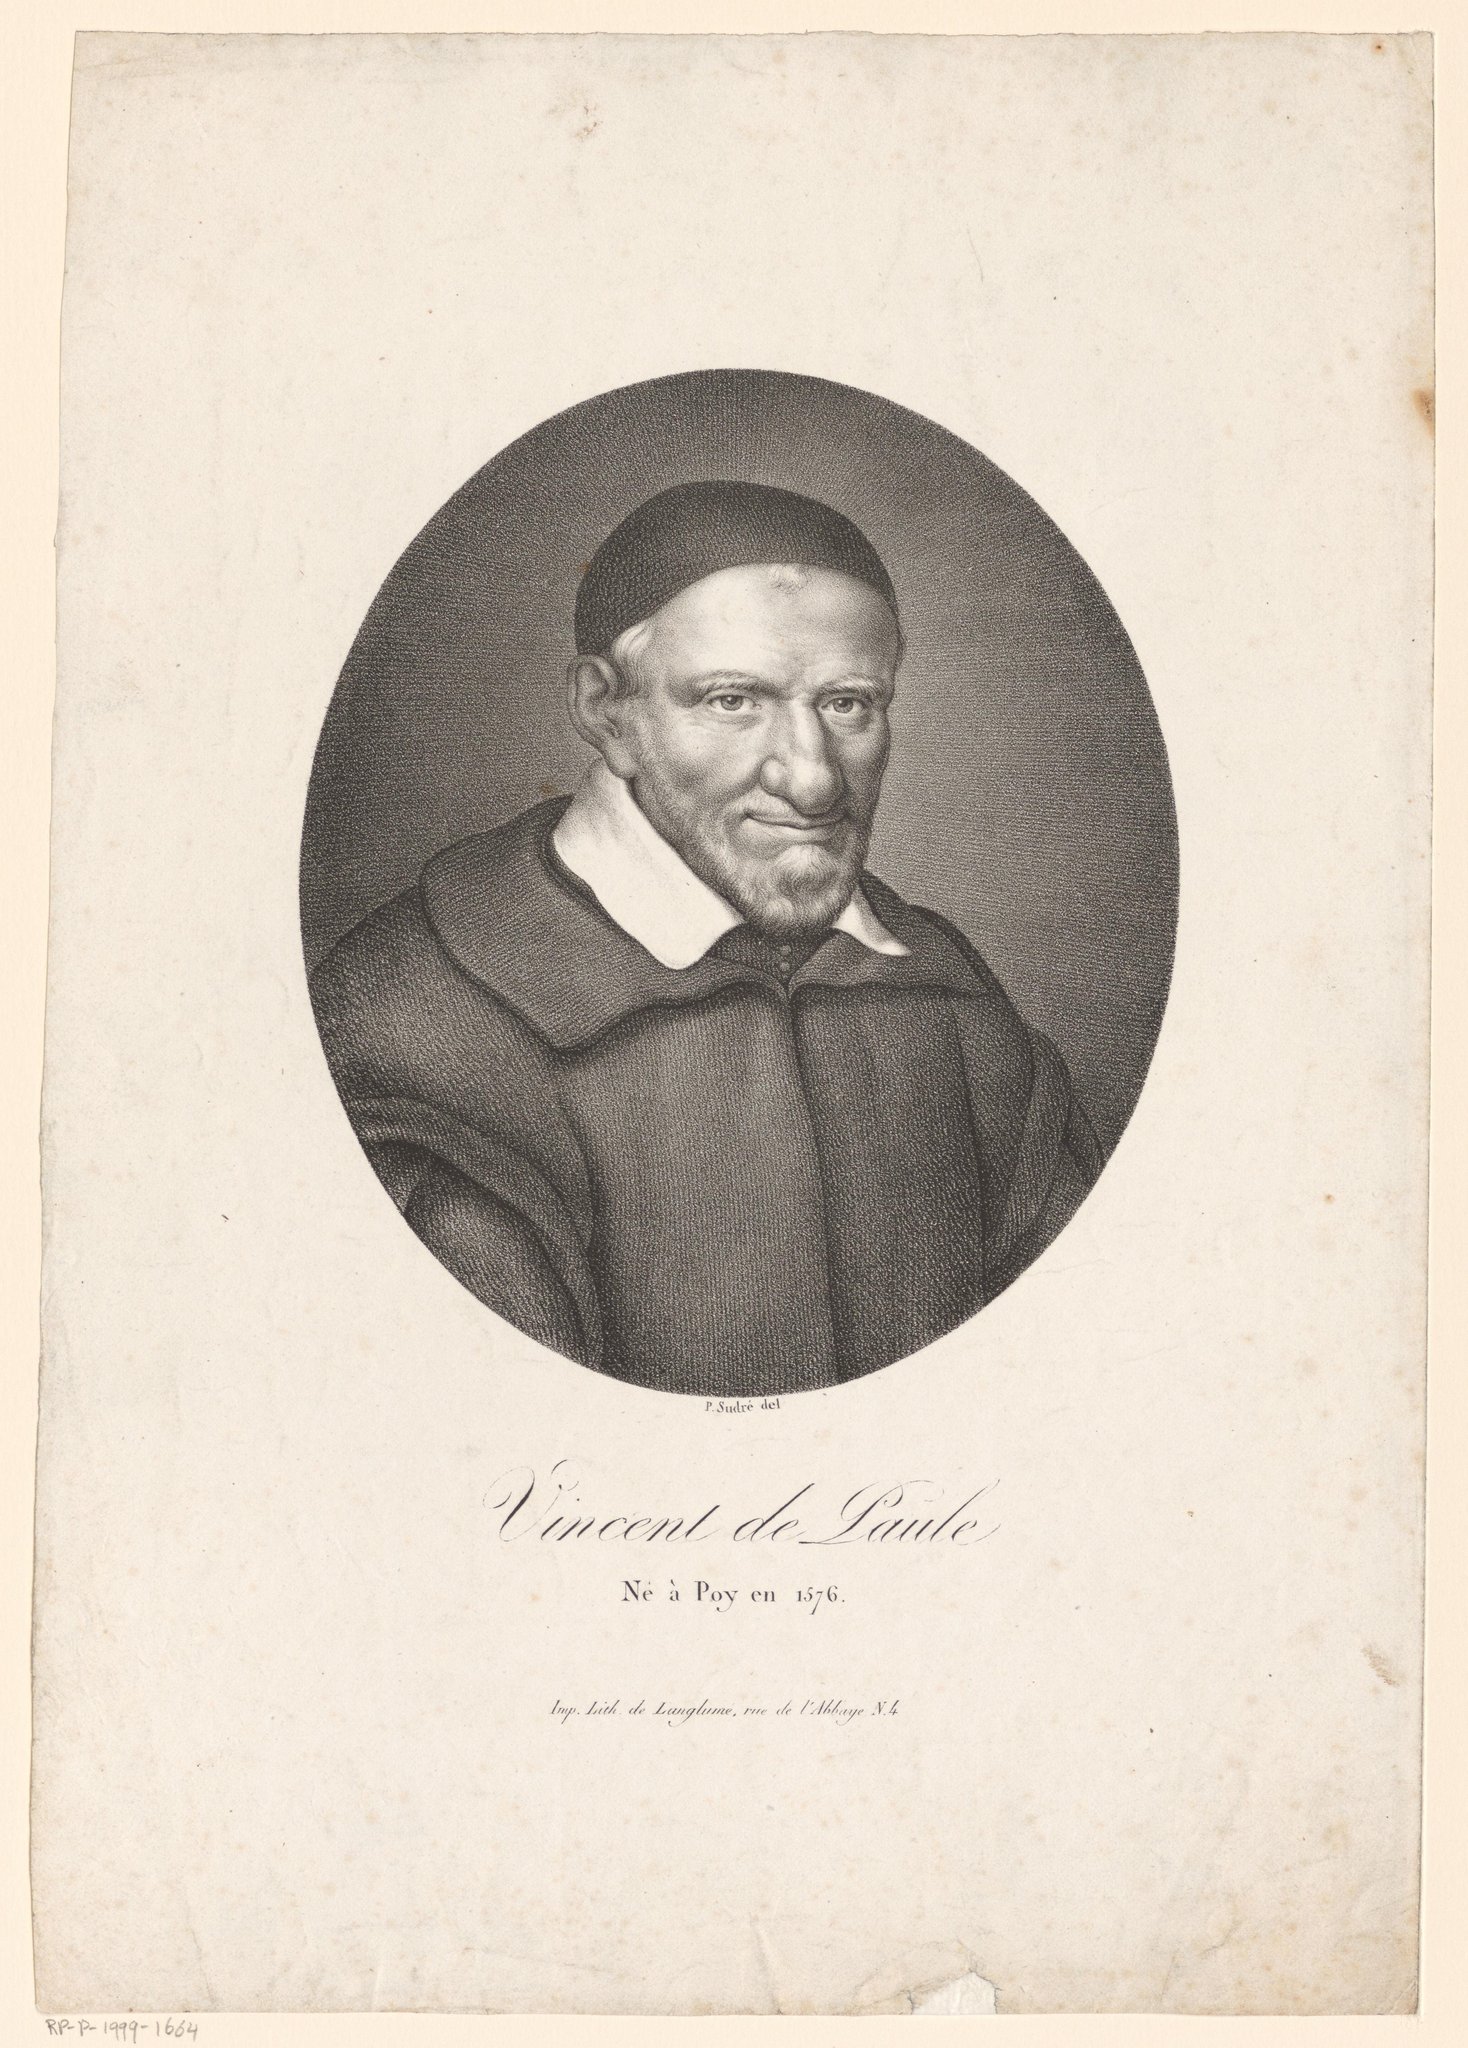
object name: print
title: Portret van Vincent de Paul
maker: pierre langlumé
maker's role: printer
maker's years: 1790-1830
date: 1815-1830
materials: paper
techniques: lithograph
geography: paris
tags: adult man, male saints (with name), historical persons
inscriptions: collector's mark: Lugt 2760, collector's mark: Lugt 2228, inscription: ‘M ri/ Mag. 25. VI 08/ LB XXIII 433377 Paulo’